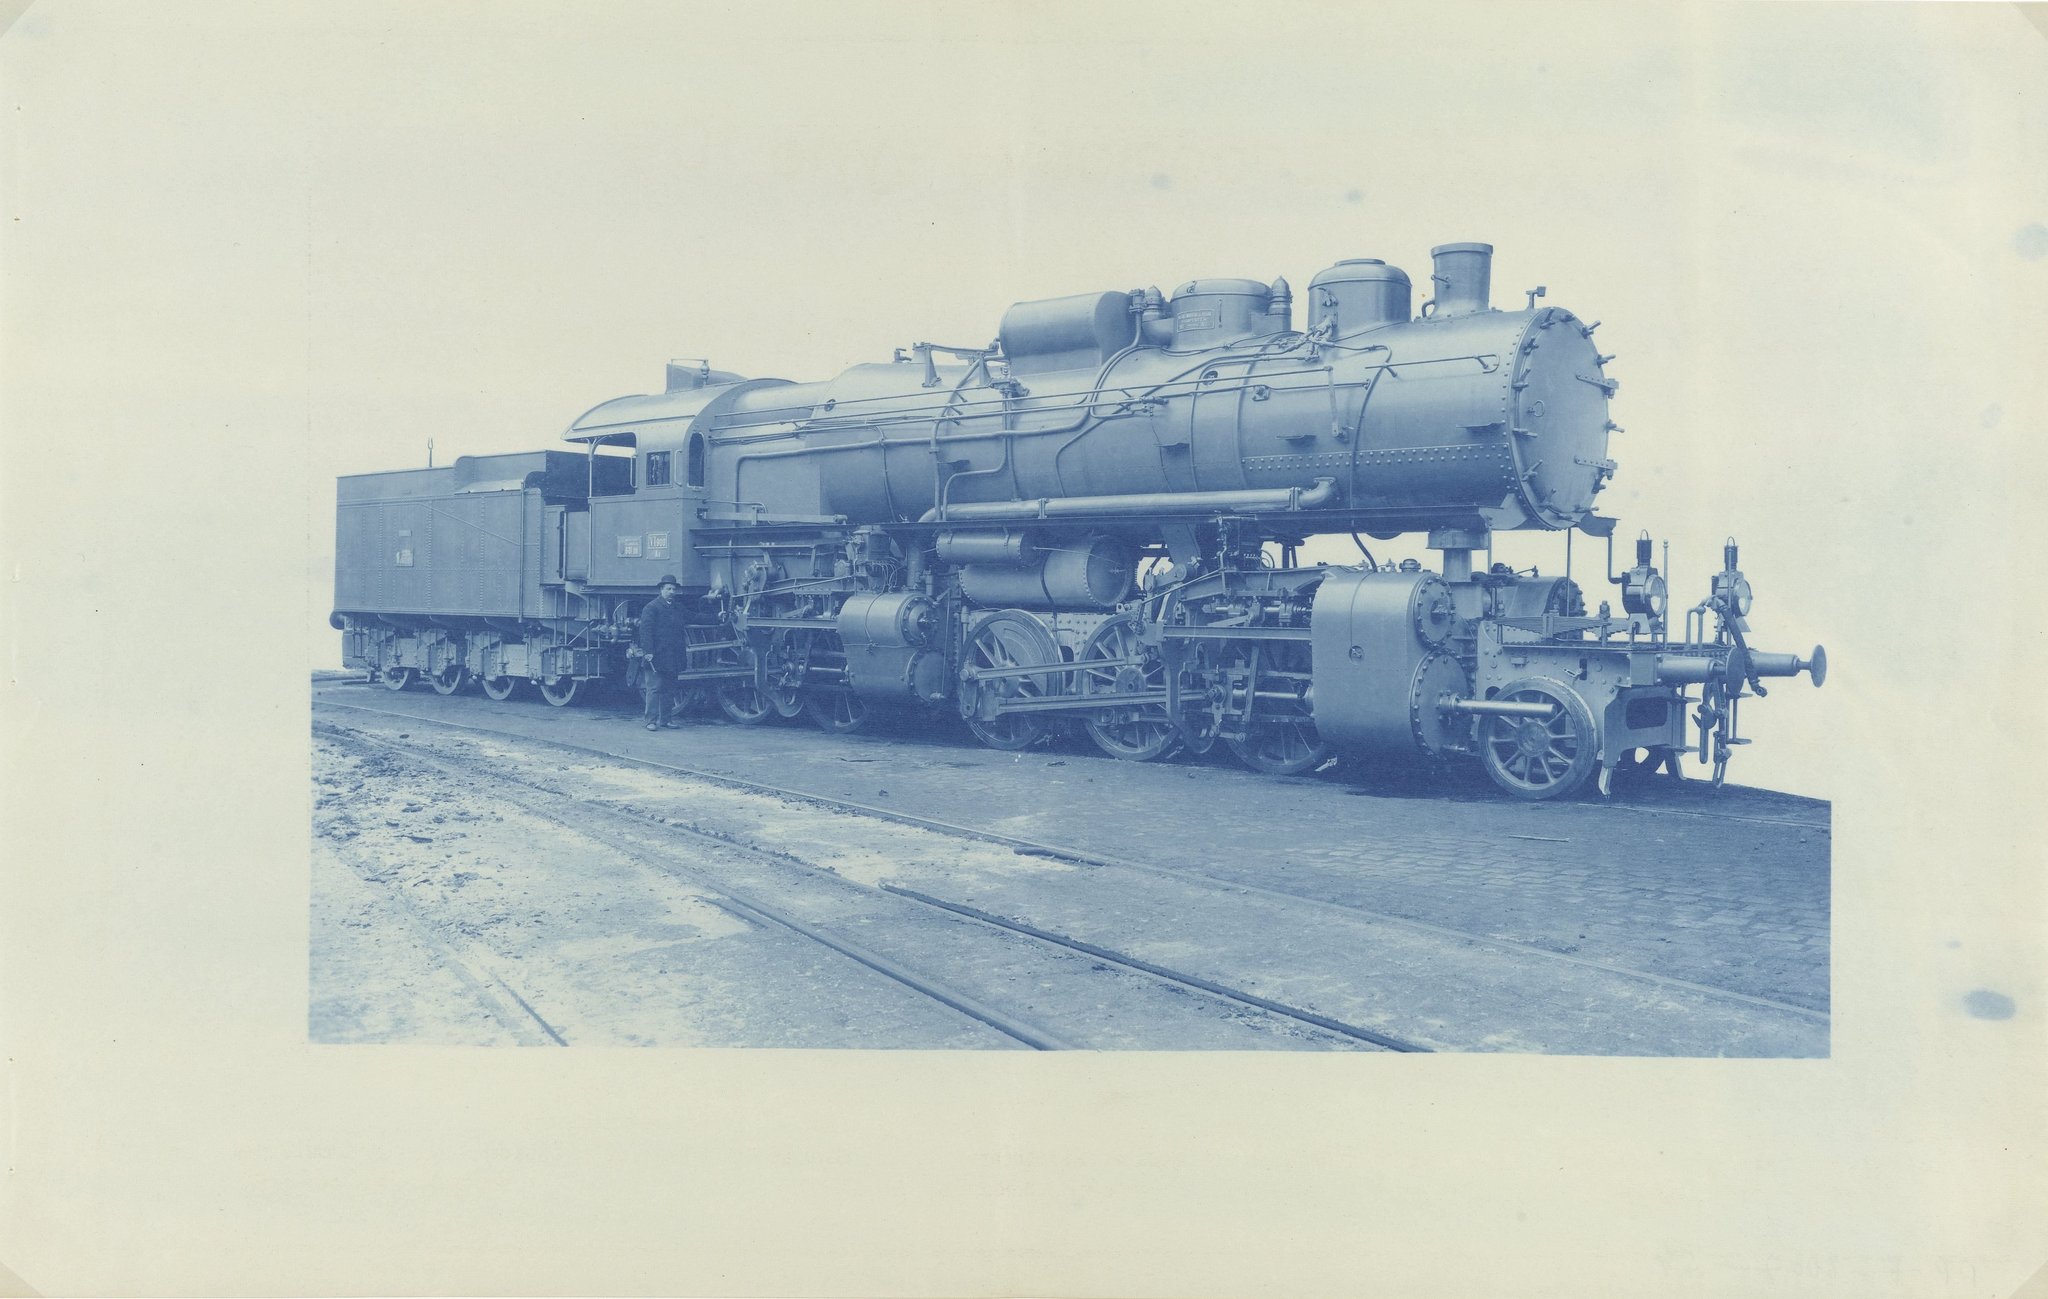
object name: photograph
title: Locomotief 601.001 van de Hongaarse Staatspoorwegen (Magyar Államvasutak, MÁV), gebouwd door Magyar Állami Vasgyárak (MÁVAG) in Budapest in 1914, met (op een los vel gedrukt) technische specificaties.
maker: Anonymous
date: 1890-1915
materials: paper, photographic support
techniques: cyanotype, letterpress printing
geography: north and central america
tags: railway, train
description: Locomotief van de MÁV-serie 601, gebouwd door MÁVAG uit Boedapest (jaren 1914-20), met (op een los vel gedrukt) technische specificaties.